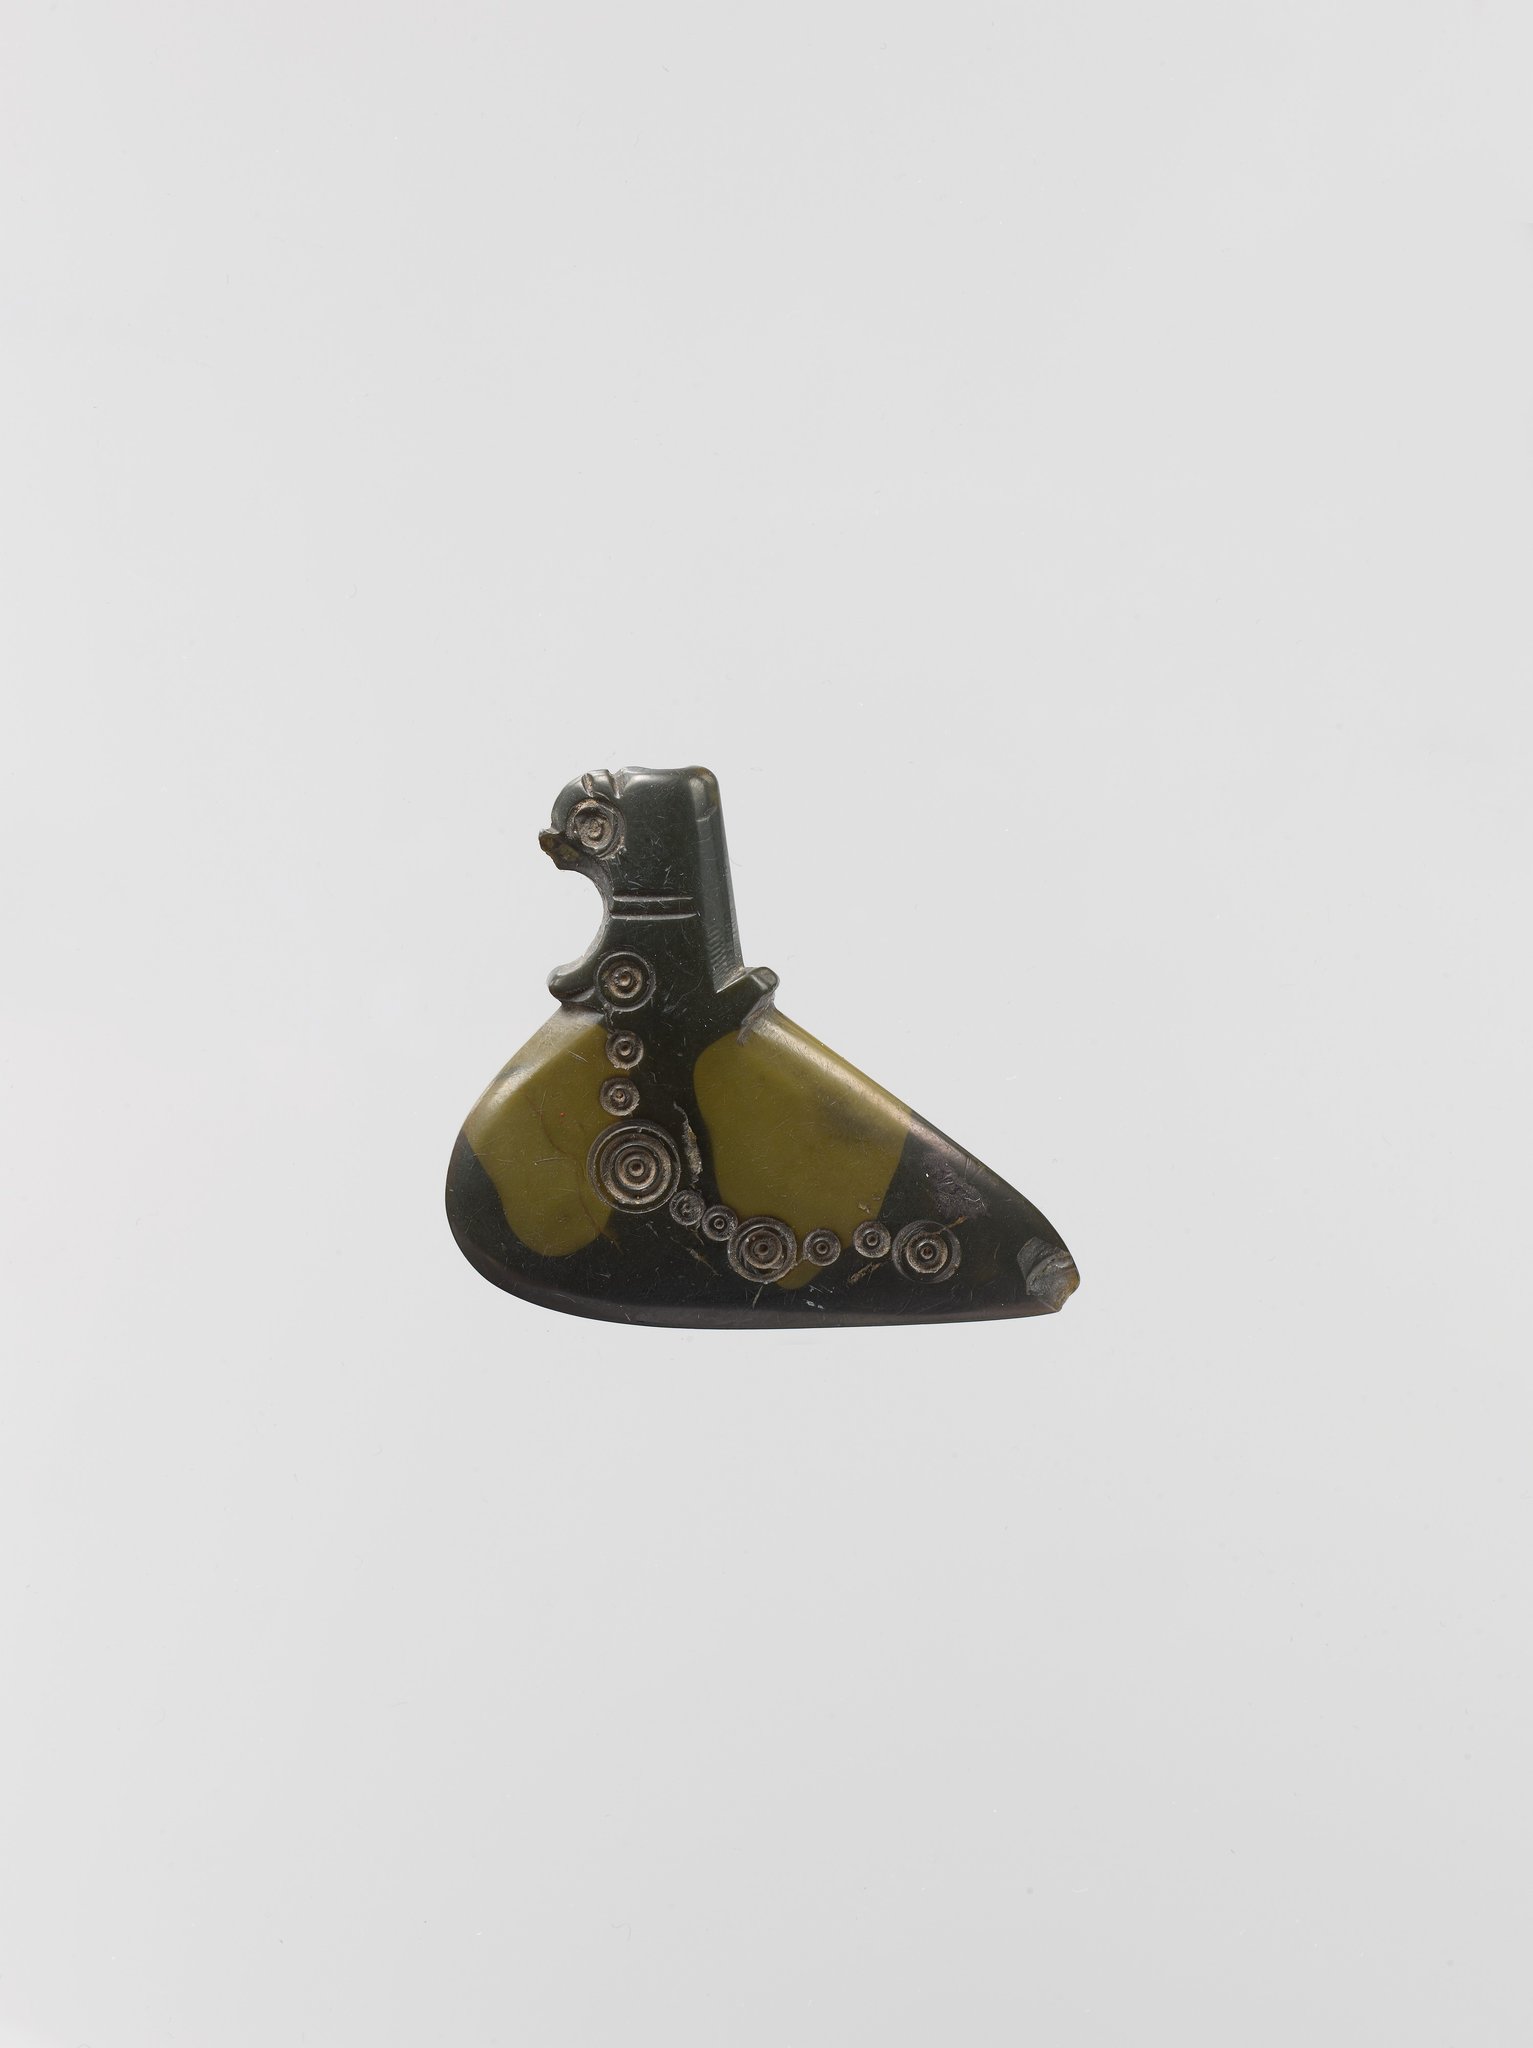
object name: kohl flask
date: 901-1200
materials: stone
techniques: carving, incising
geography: iran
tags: birds